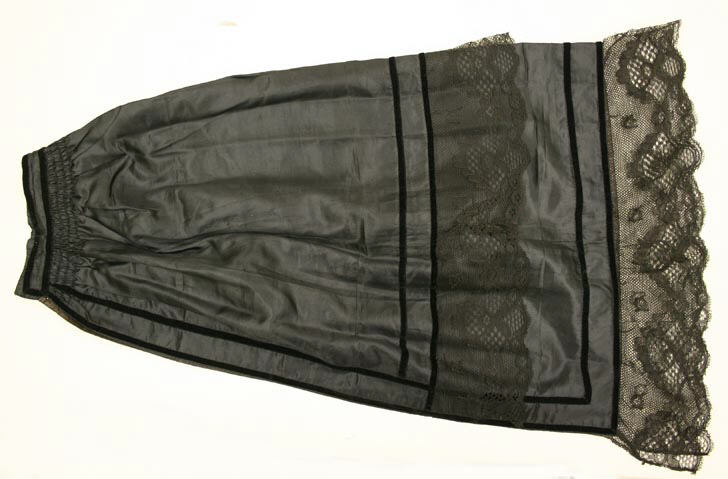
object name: apron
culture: american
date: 1880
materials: cotton